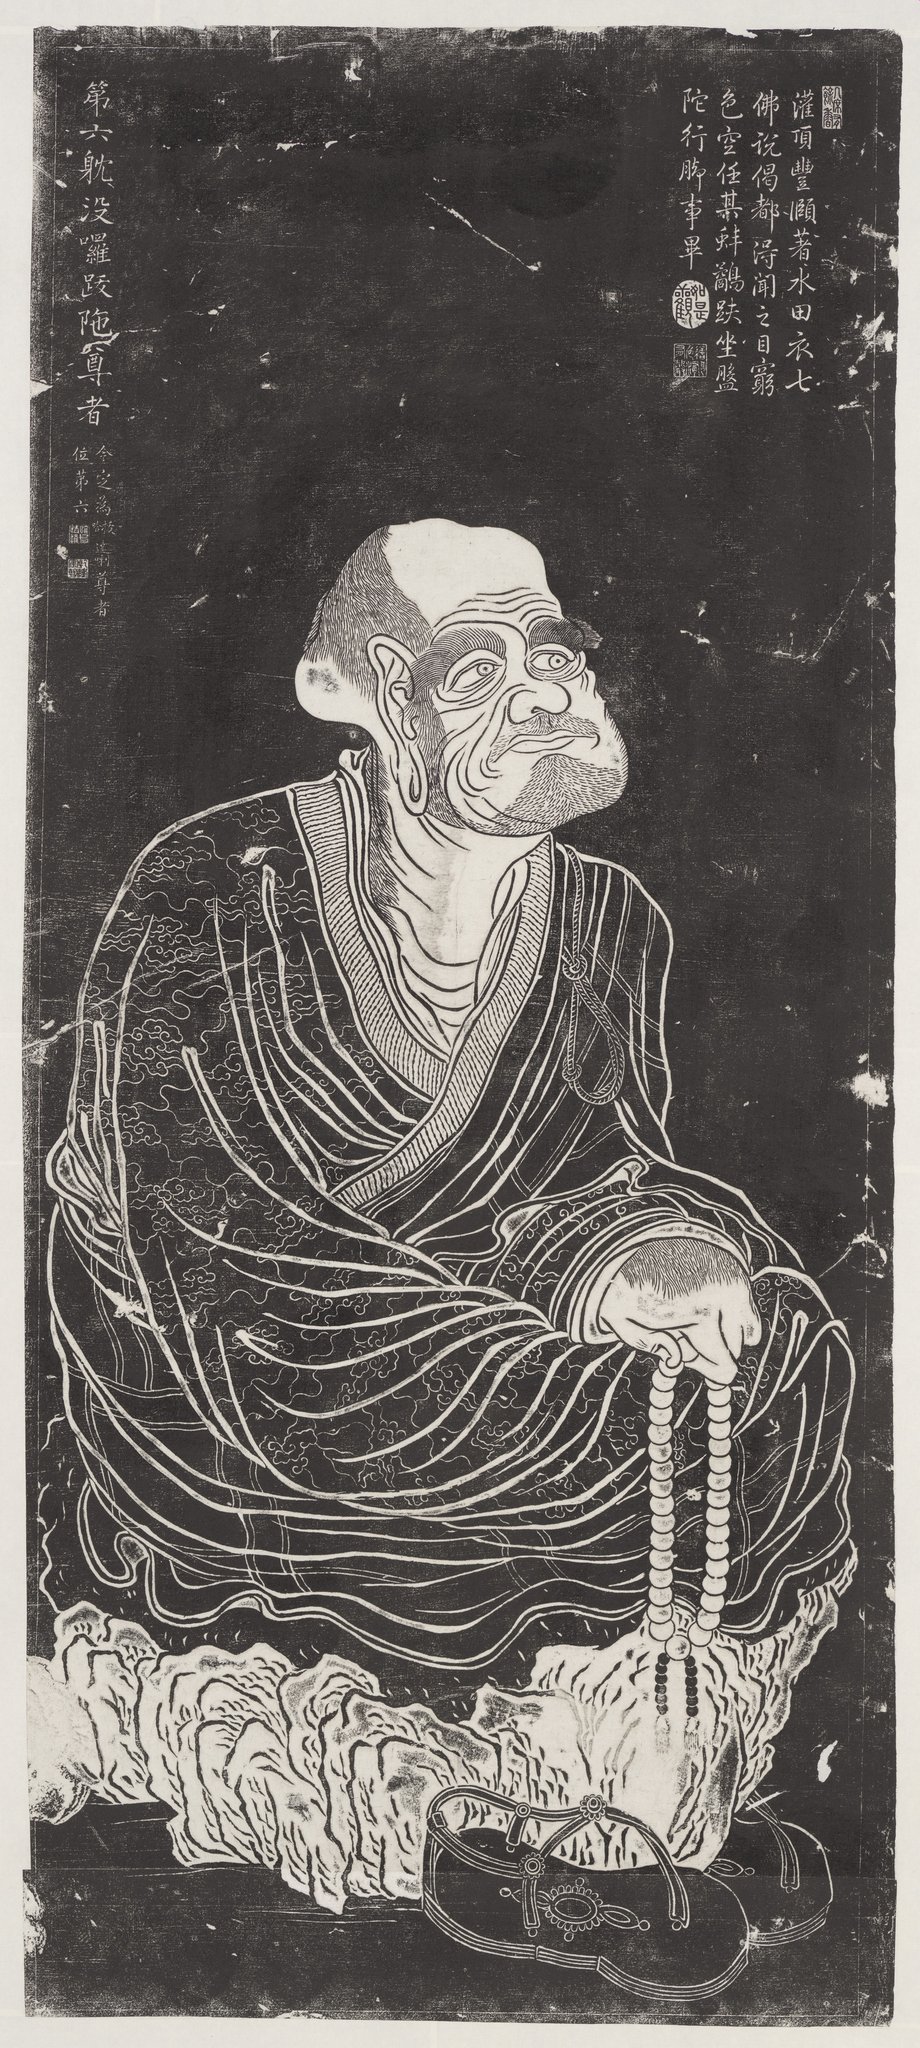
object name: rubbing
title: Luohan, after a set attributed to Guanxiu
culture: chinese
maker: unidentified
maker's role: artist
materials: ink, paper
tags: men